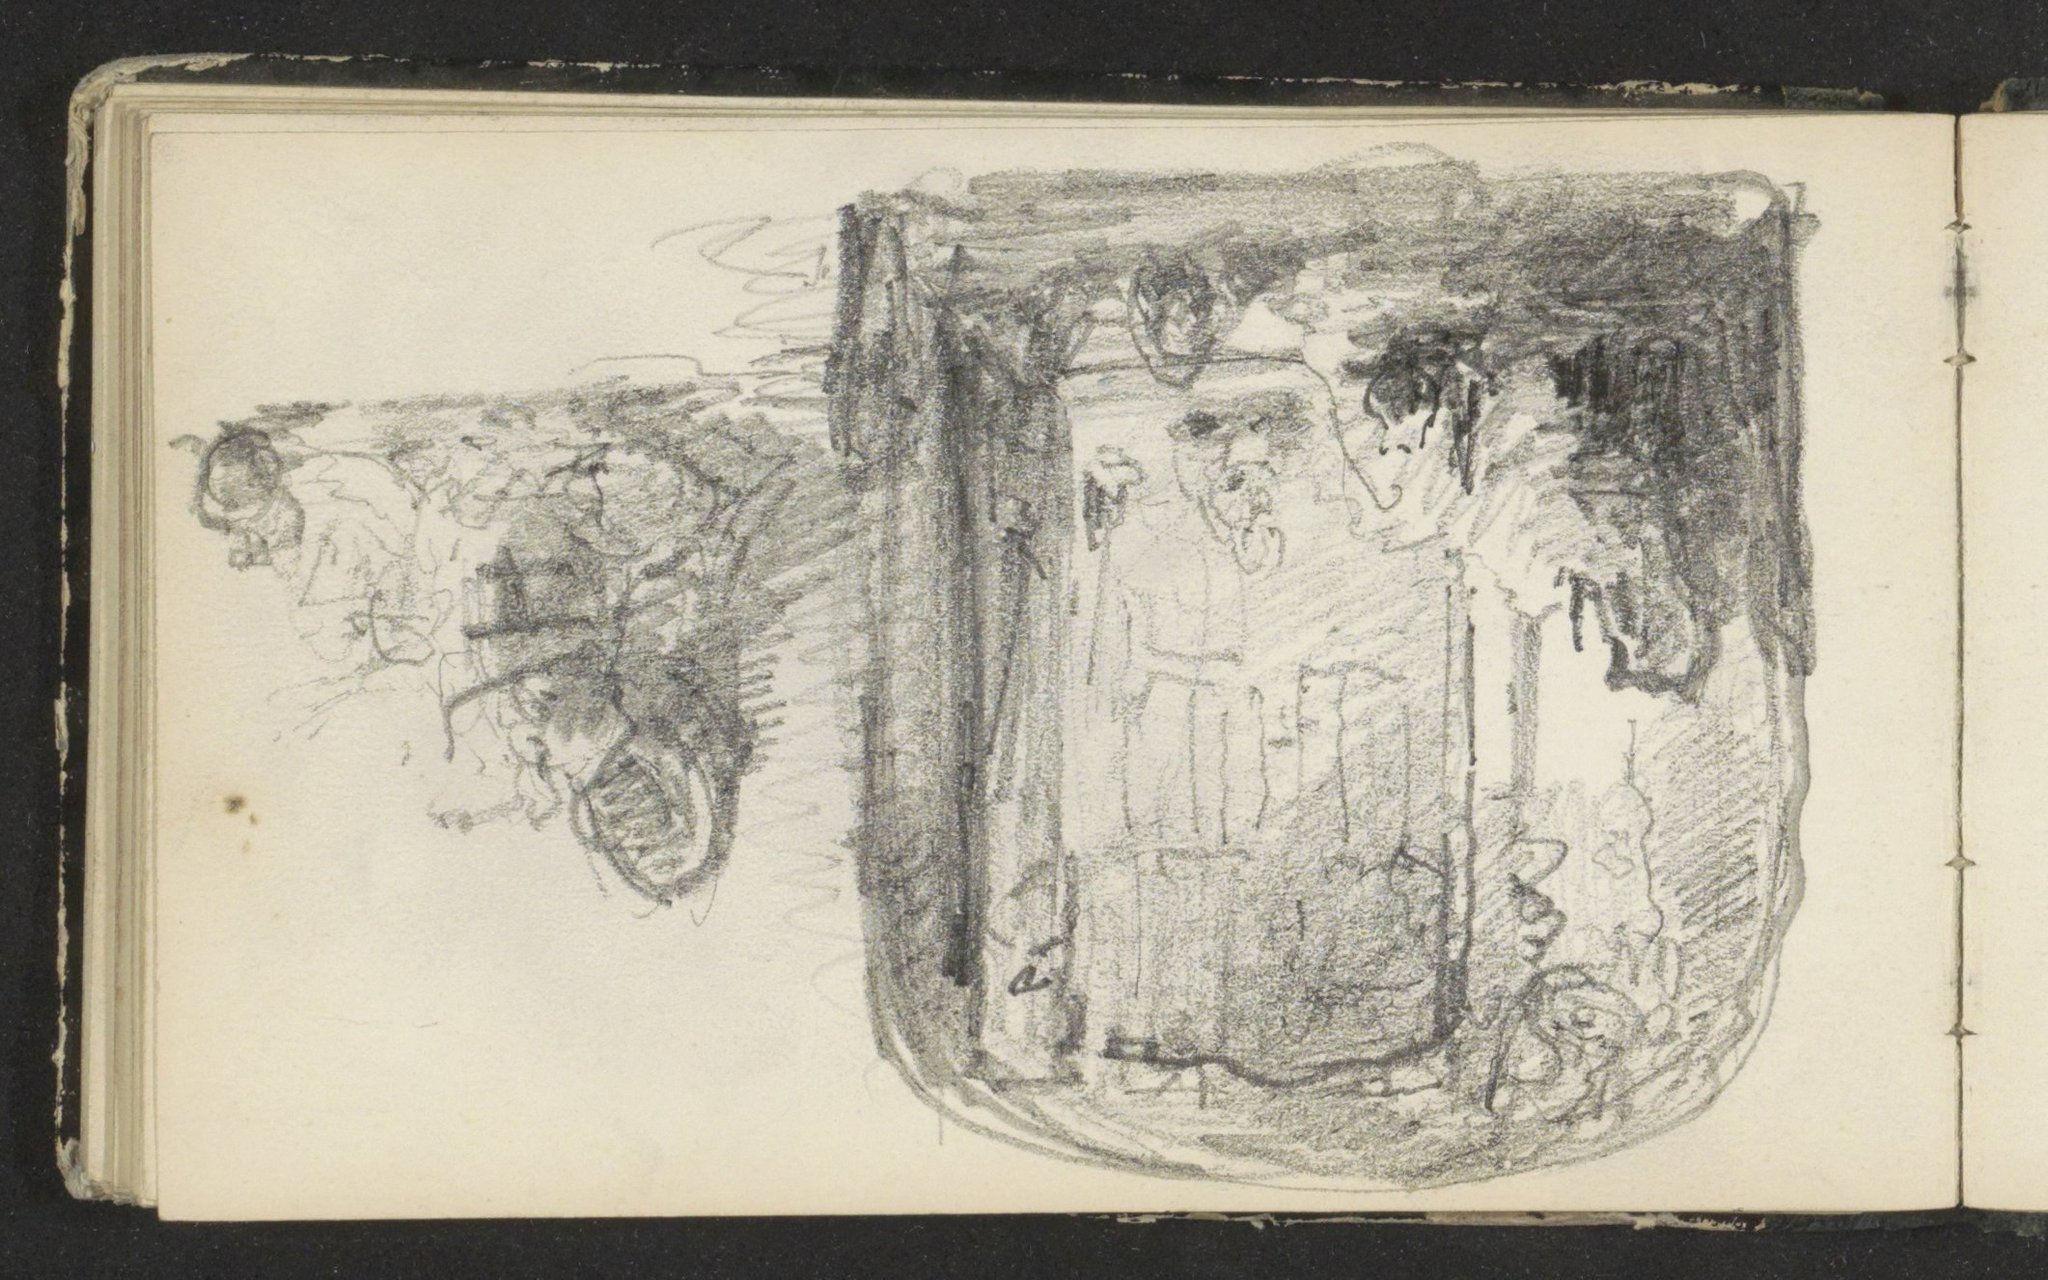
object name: sketchbook leaf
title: Opslagruimte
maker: maria vos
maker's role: draughtsman, painter, print maker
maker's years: 1824-1906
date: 1834-1906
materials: paper, pencil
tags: storage space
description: In de ruimte staan vermoedelijk etensvoorraden opgeslagen. Blad 36 verso uit een schetsboek met 46 bladen.